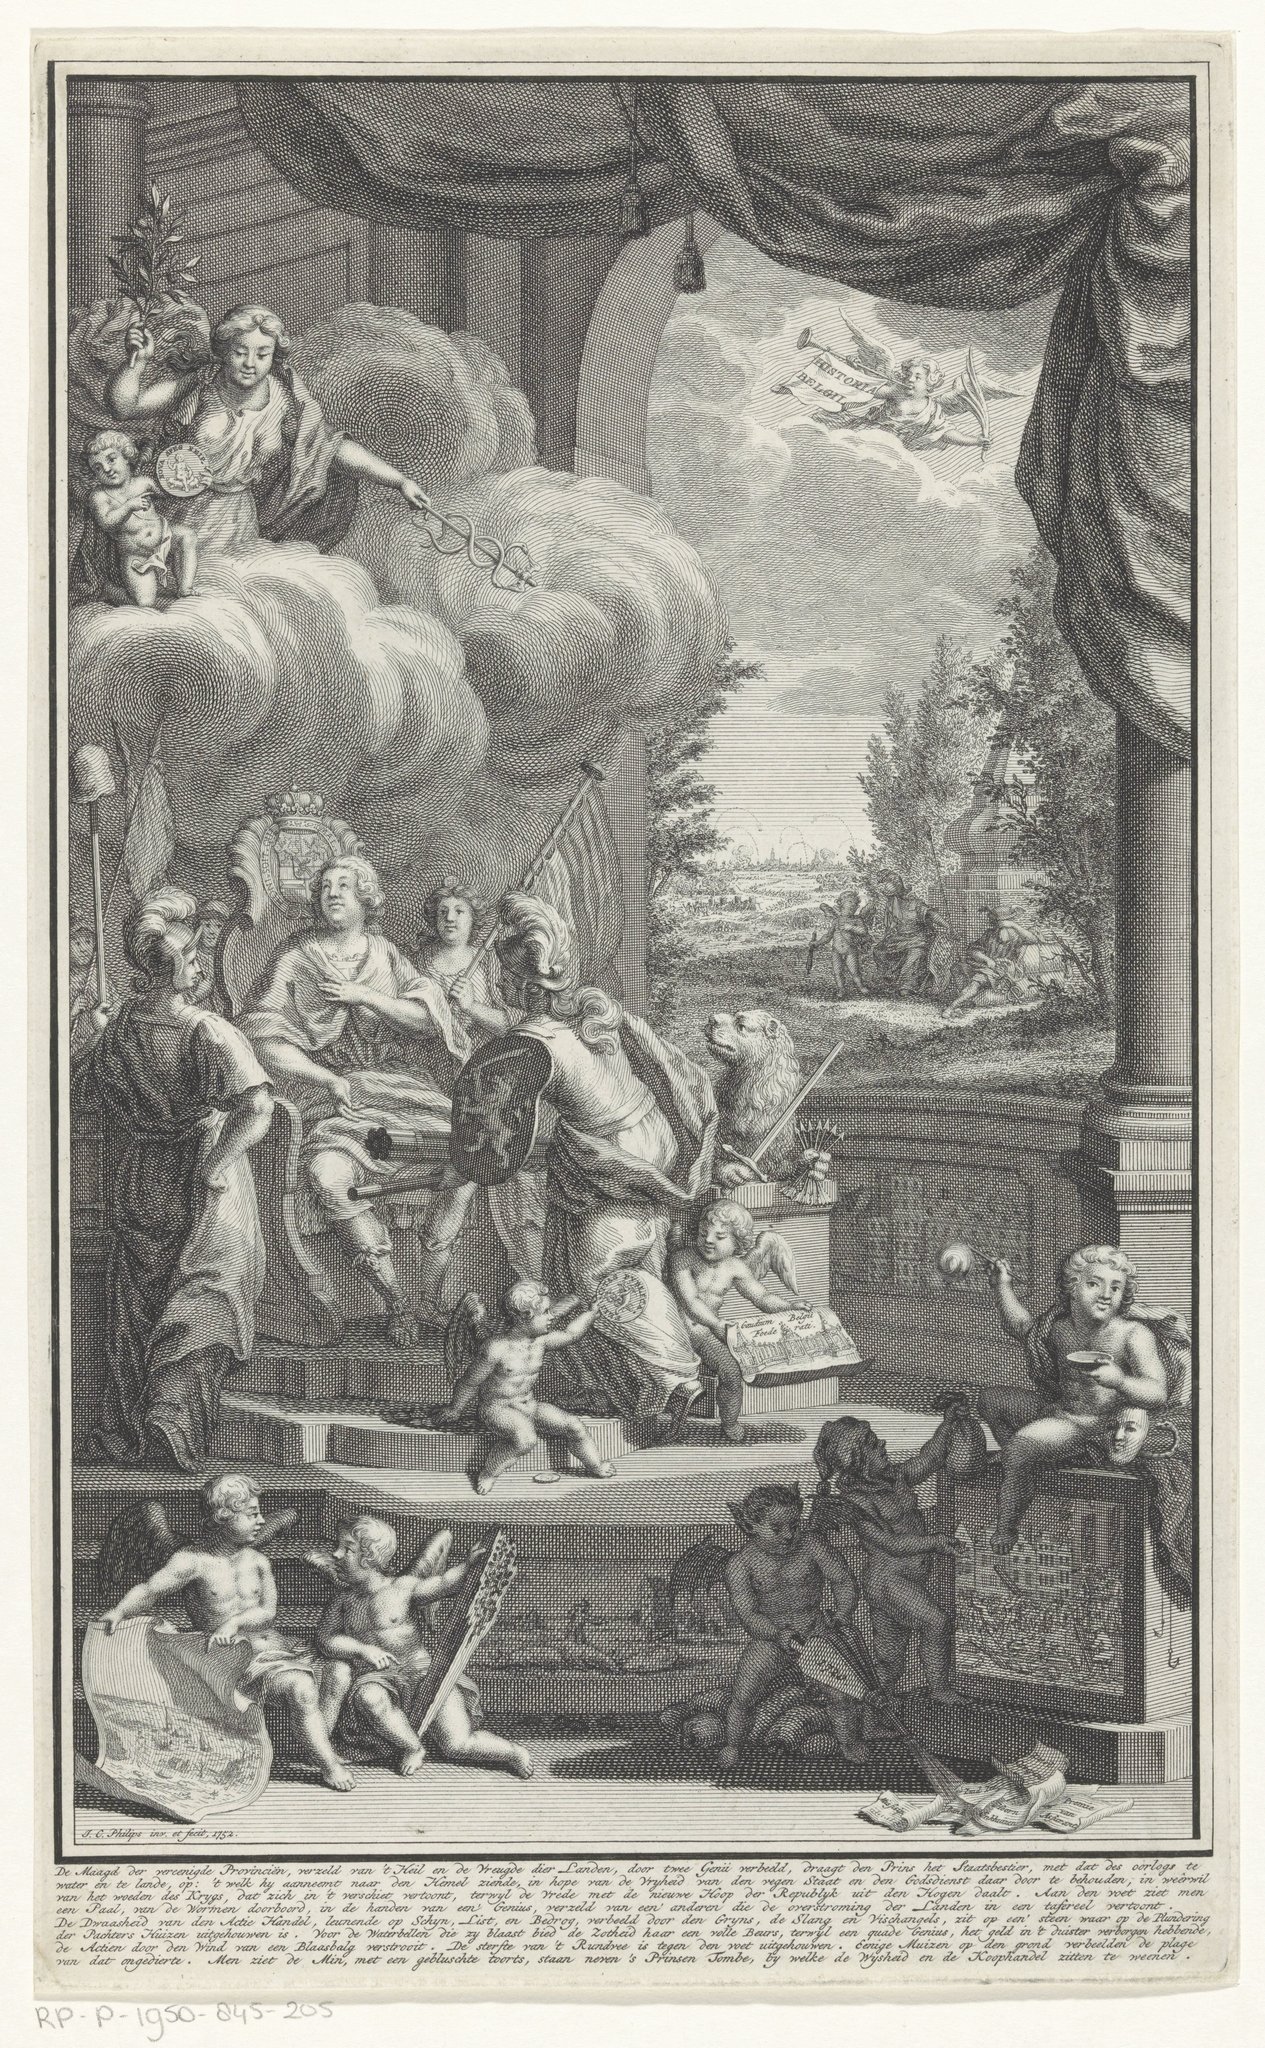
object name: print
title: Titelpagina voor: Pieter Le Clercq, Geschiedenissen der Vereenigde Nederlanden, 1753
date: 1752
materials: paper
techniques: engraving, etching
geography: amsterdam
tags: the hague, willem iv (prins van oranje-nassau), personifications of countries, nations, states, districts, etc., prince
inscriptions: collector's mark: Lugt 2228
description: Allegorie op de verheffing van Willem IV tot erfstadhouder, 1747. Hij zit op een troon en ontvangt van de Nederlandse Maagd het staatsbestuur. In de wolken de Vrede en blaast Fama op een bazuin met de vaandel Historia Belgii. Op de voorgrond putti die verwijzen naar de Windhandel van 1720. Op de achtergrond treuren Minerva en Mercurius bij de graftombe van de in 1751 overleden prins. In de ondermarge een achtregelige Nederlandse tekst.